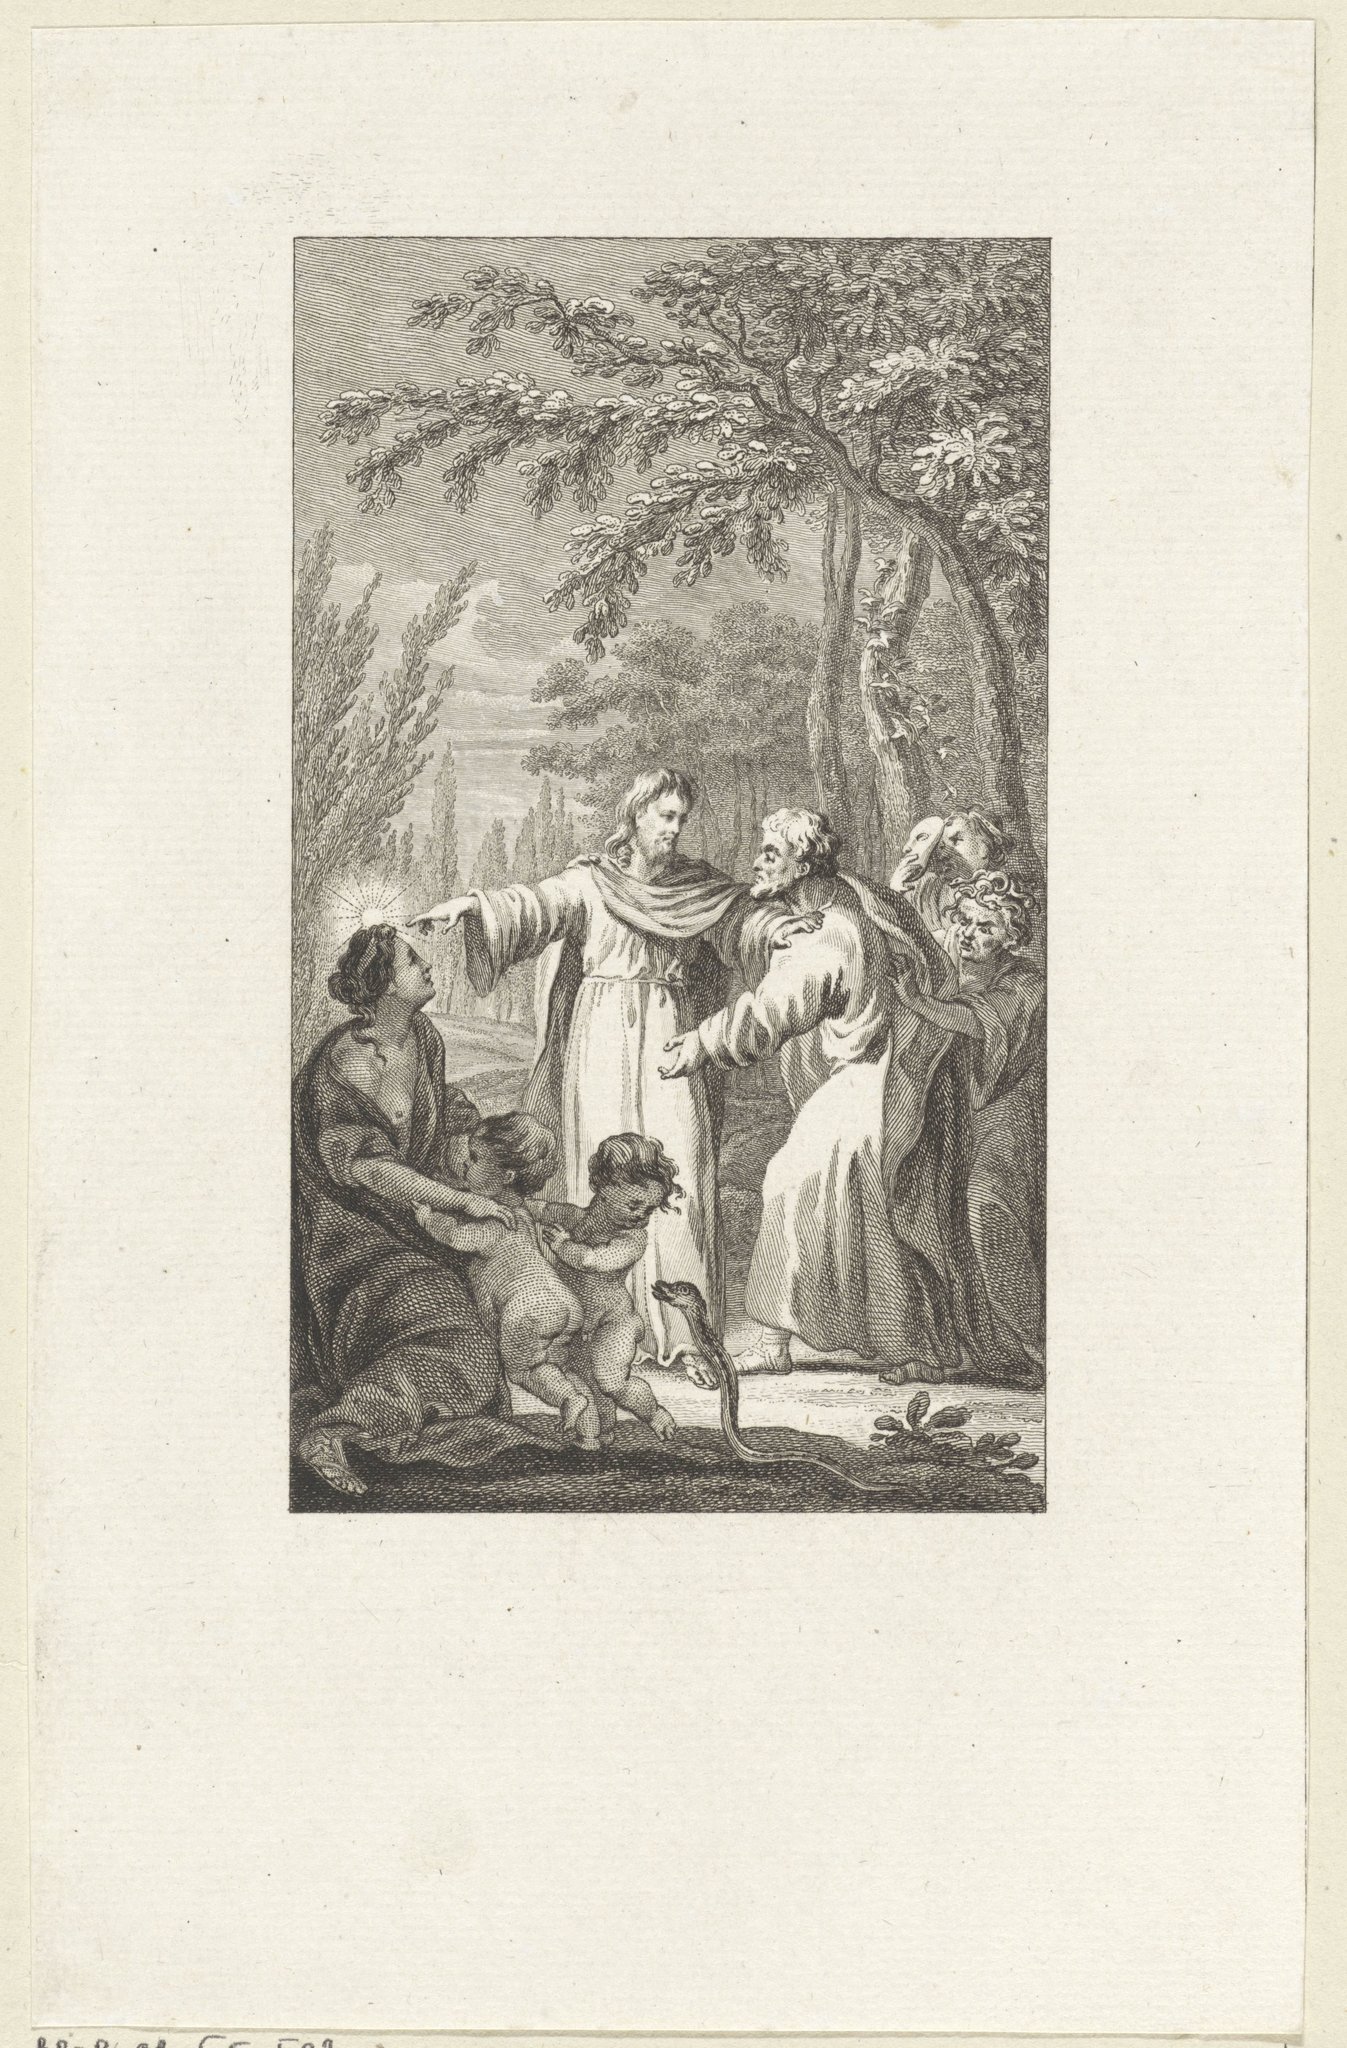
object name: print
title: Allegorie met Christus als Vriendschap en Judas als Bedrog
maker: reinier vinkeles (i)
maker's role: draughtsman, print maker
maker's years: 1741-1816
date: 1777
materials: paper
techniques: engraving, etching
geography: amsterdam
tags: 'tradimento' (ripa), christ, friendship; 'amicitia' (ripa), judas iscariot (not in biblical context)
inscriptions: collector's mark: Lugt 240